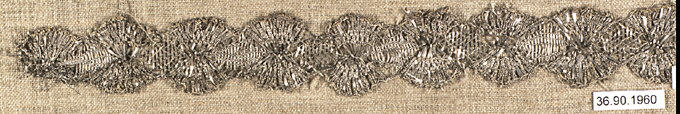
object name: piece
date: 1801-1900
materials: metal thread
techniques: lace